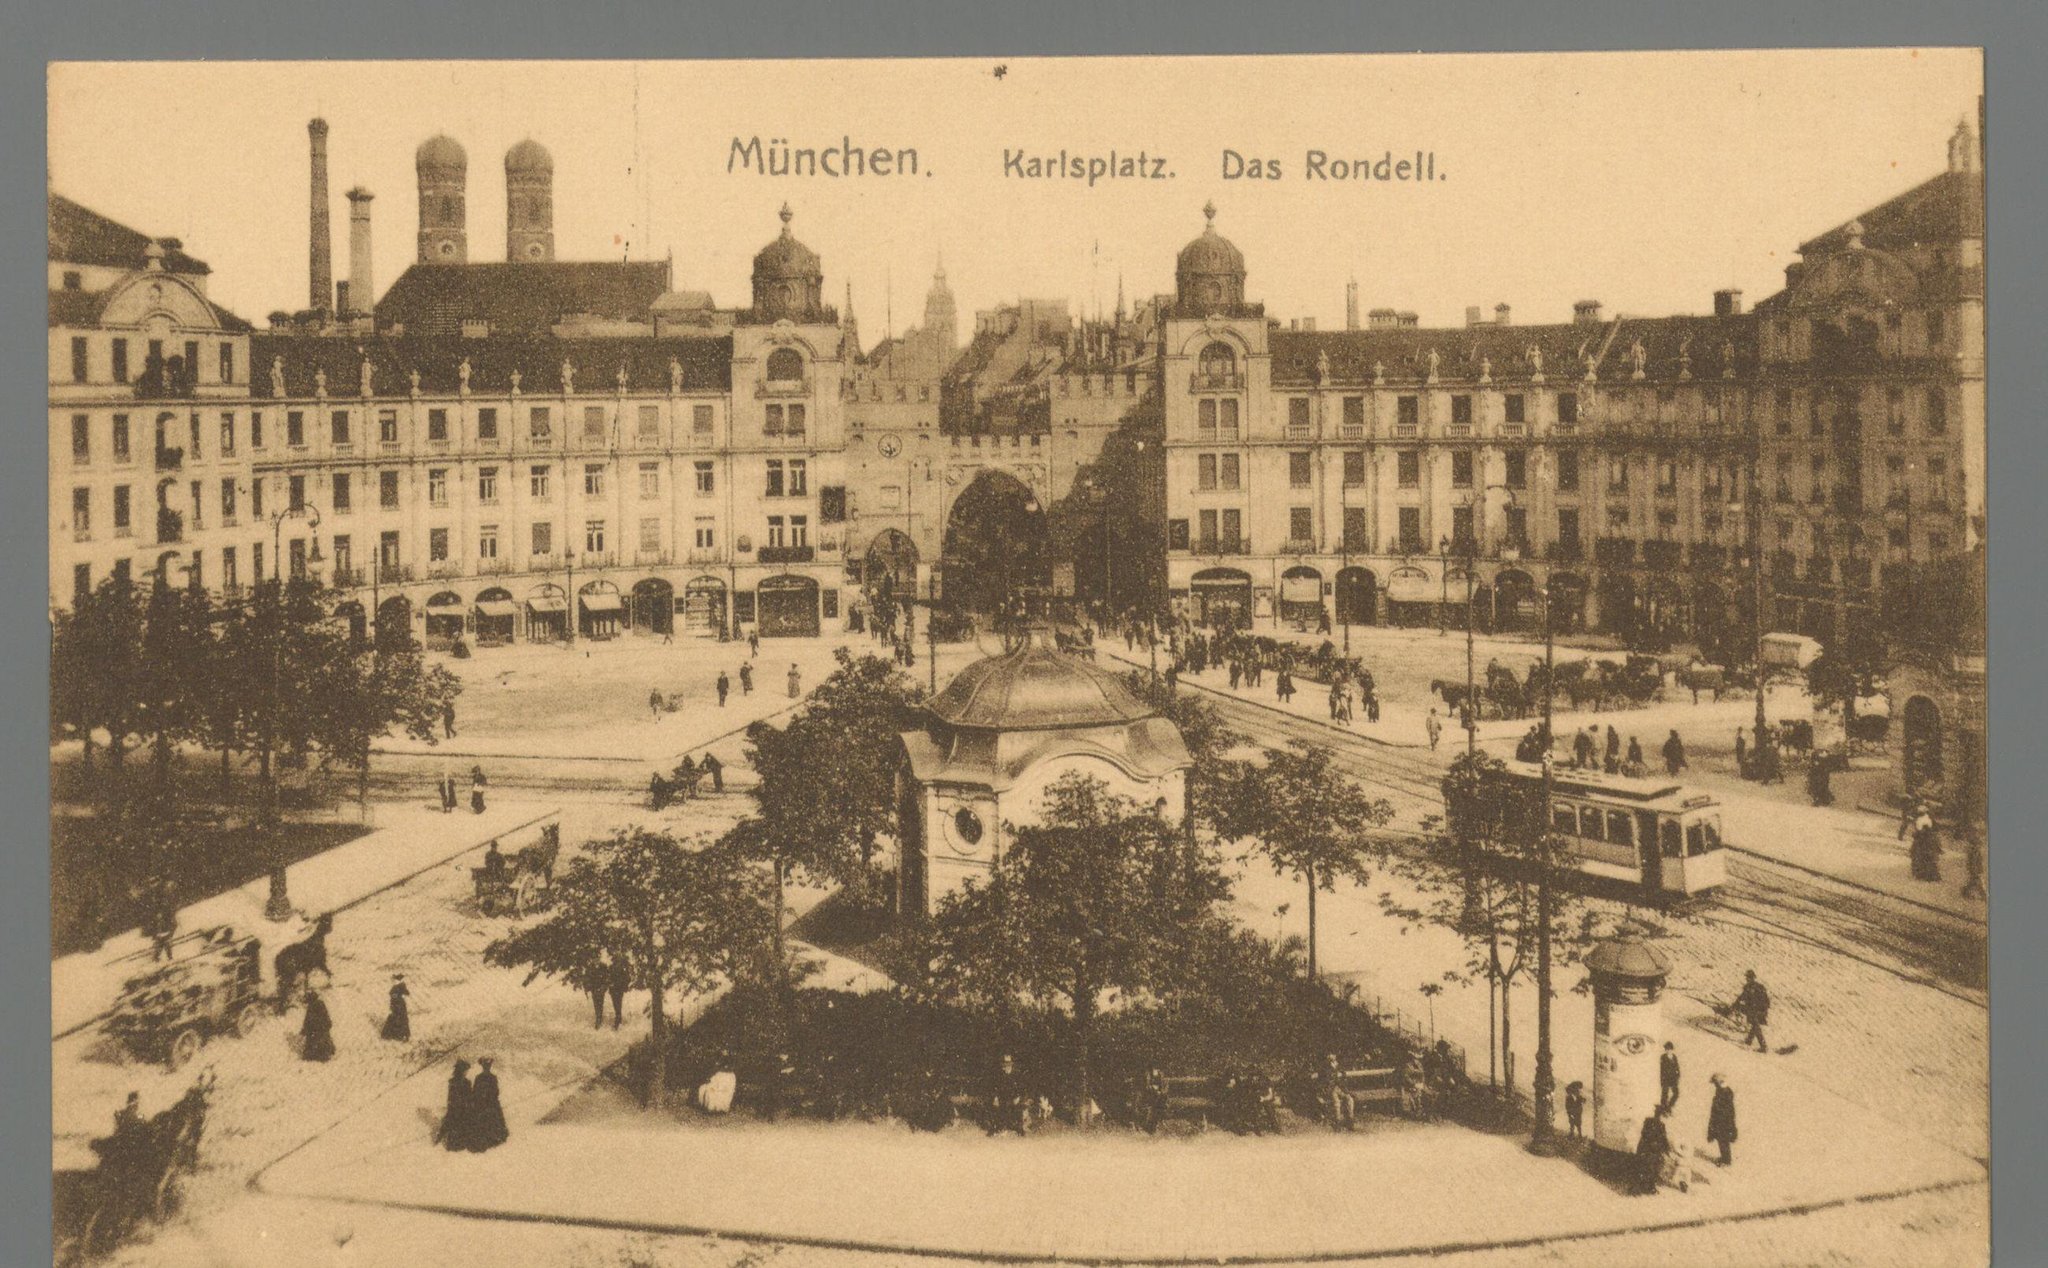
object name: photomechanical print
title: München. Karlsplatz. Das Rondell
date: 1905-1909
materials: cardboard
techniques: photograph, writing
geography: munich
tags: square, place, circus, etc.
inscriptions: inscription: ‘W.H.D.’